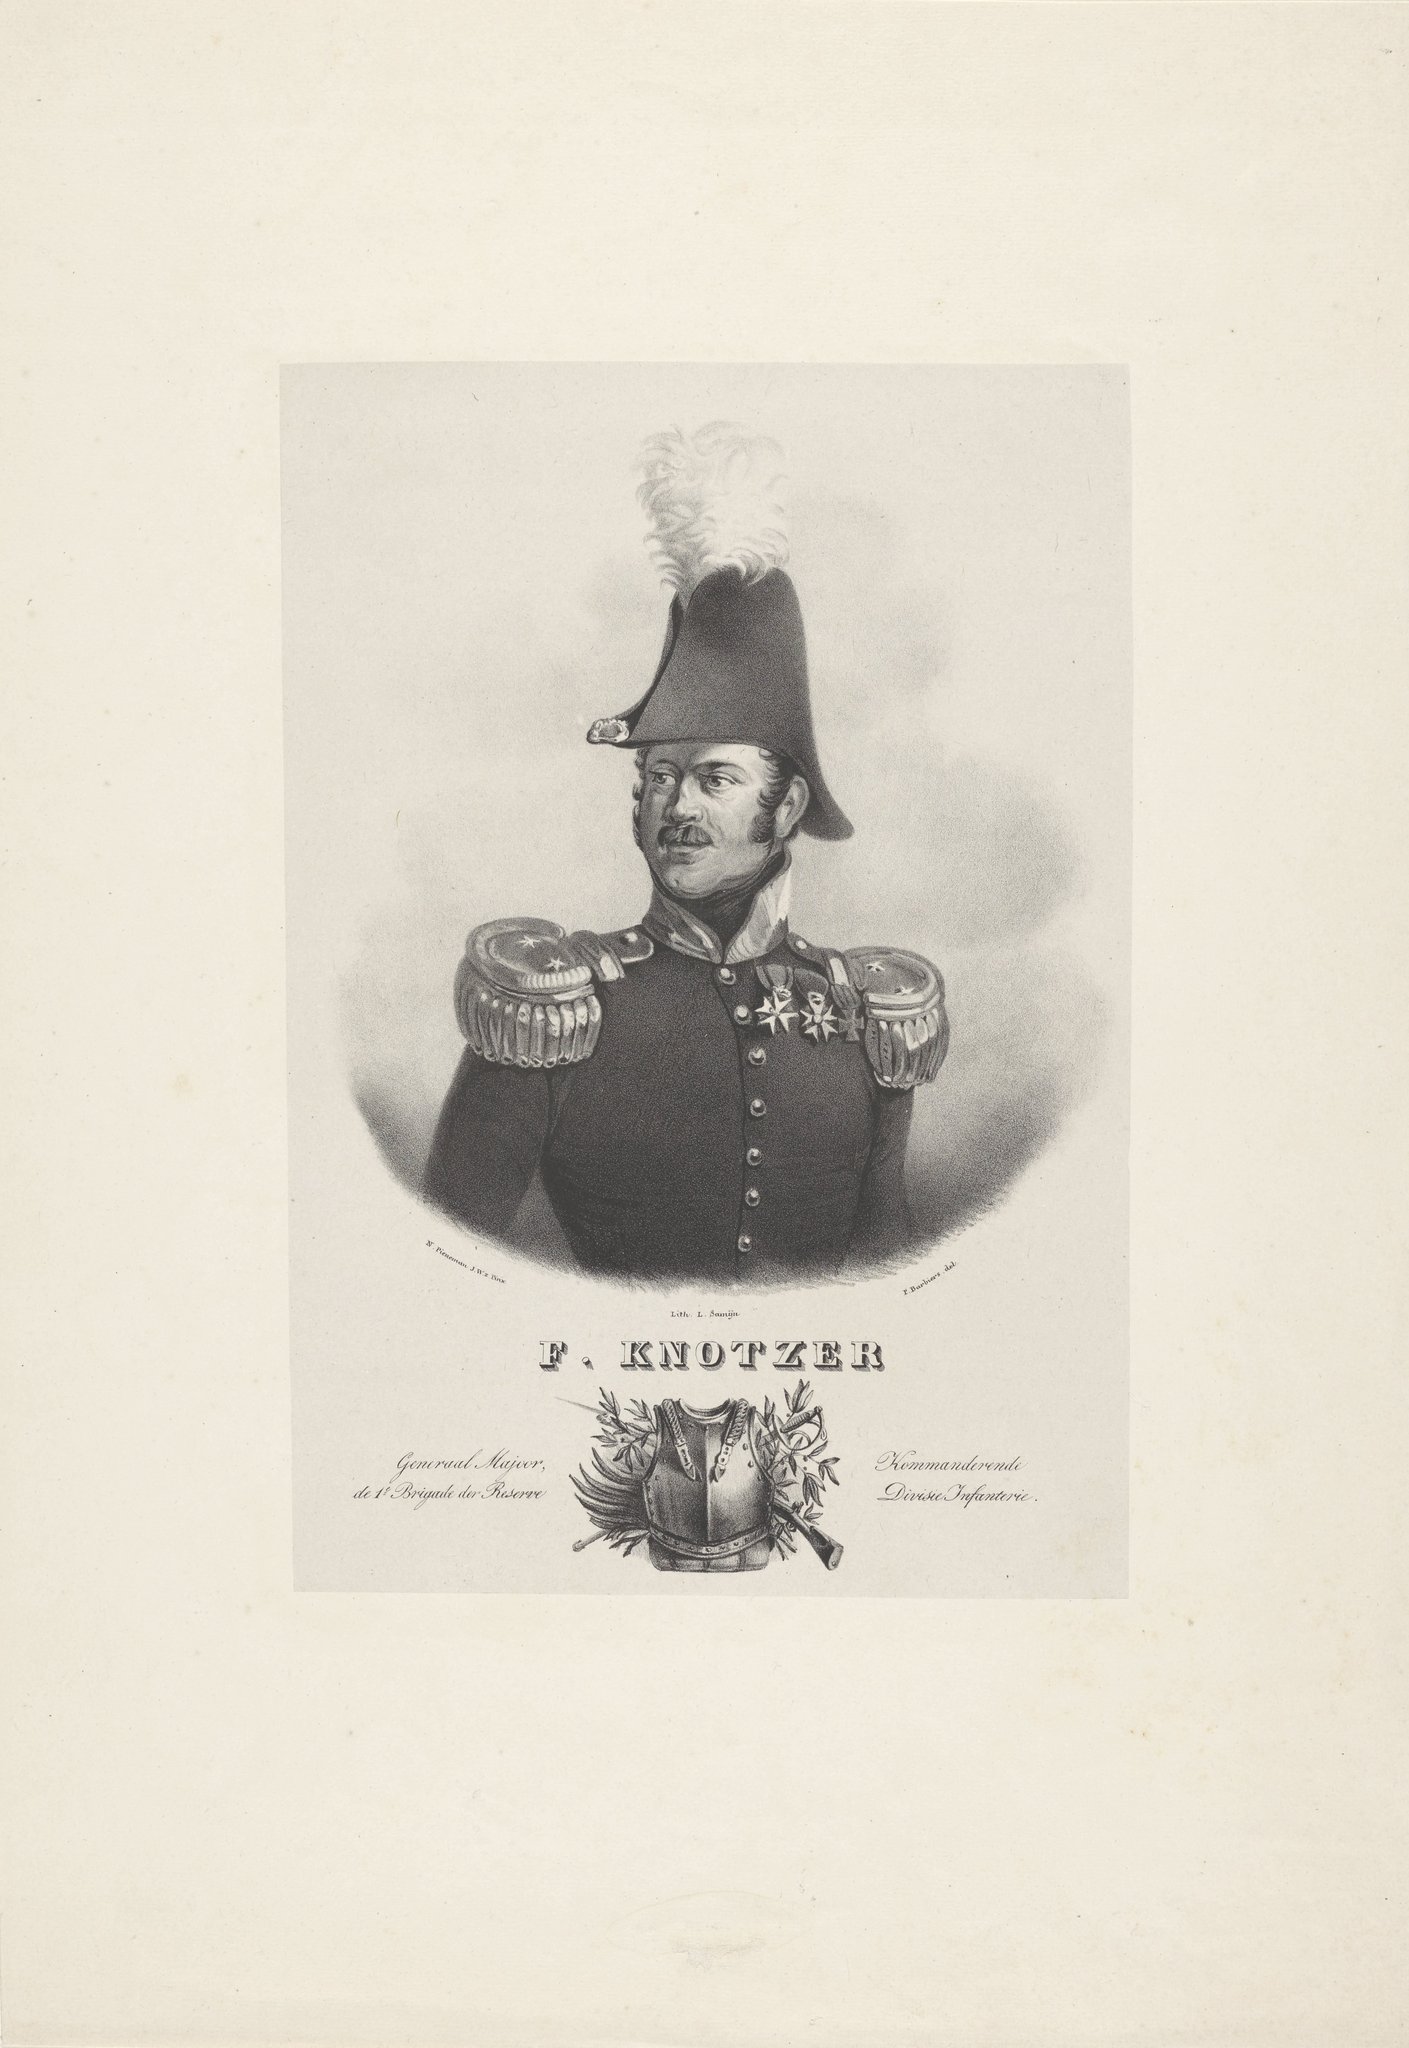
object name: print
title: Portret van Frederik Knotzer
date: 1808-1848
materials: paper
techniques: lithograph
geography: amsterdam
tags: the hague, amerongen, 'tropaion', i.e. decorative ornament ~ weapons, historical persons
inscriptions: collector's mark: Lugt 2228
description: De geportretteerde draagt een hoge hoed met pluim. Eronder de naam van de geportretteerde, zijn functies en een trofee met wapens en palmtakken.